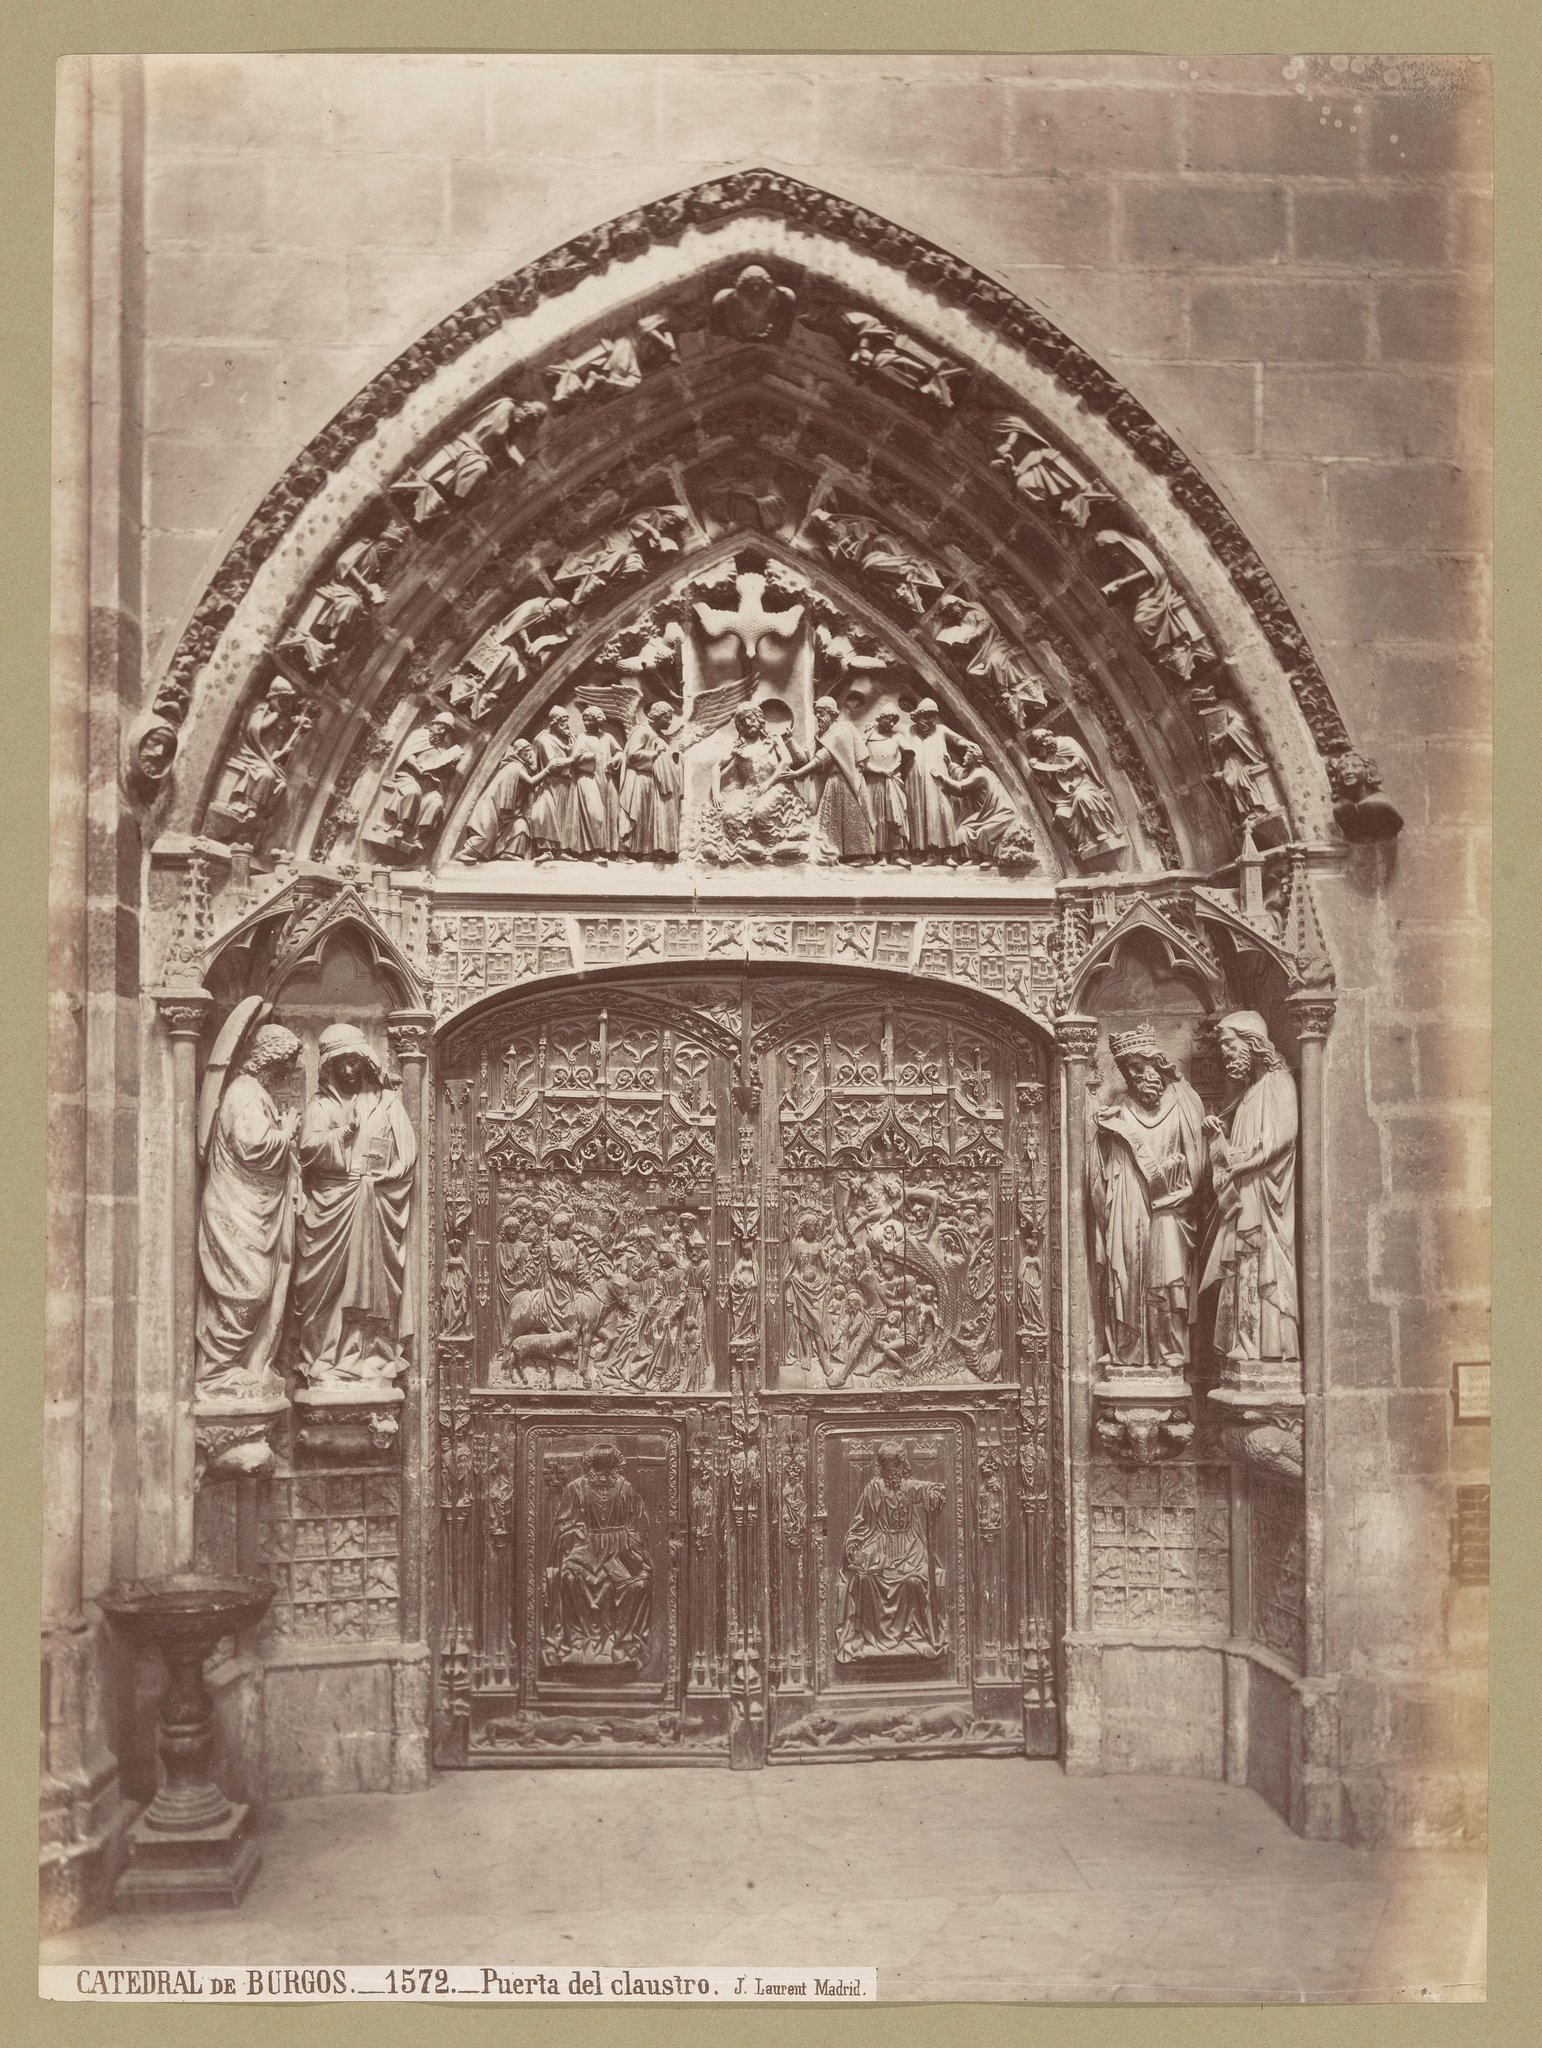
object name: photograph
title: Catedral de Burgos, puerta del claustro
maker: juan laurent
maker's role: publisher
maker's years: 1816-1896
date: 1856-1863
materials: paper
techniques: albumen print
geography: burgos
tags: parts of church exterior and annexes: portal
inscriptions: number: ‘1572.’